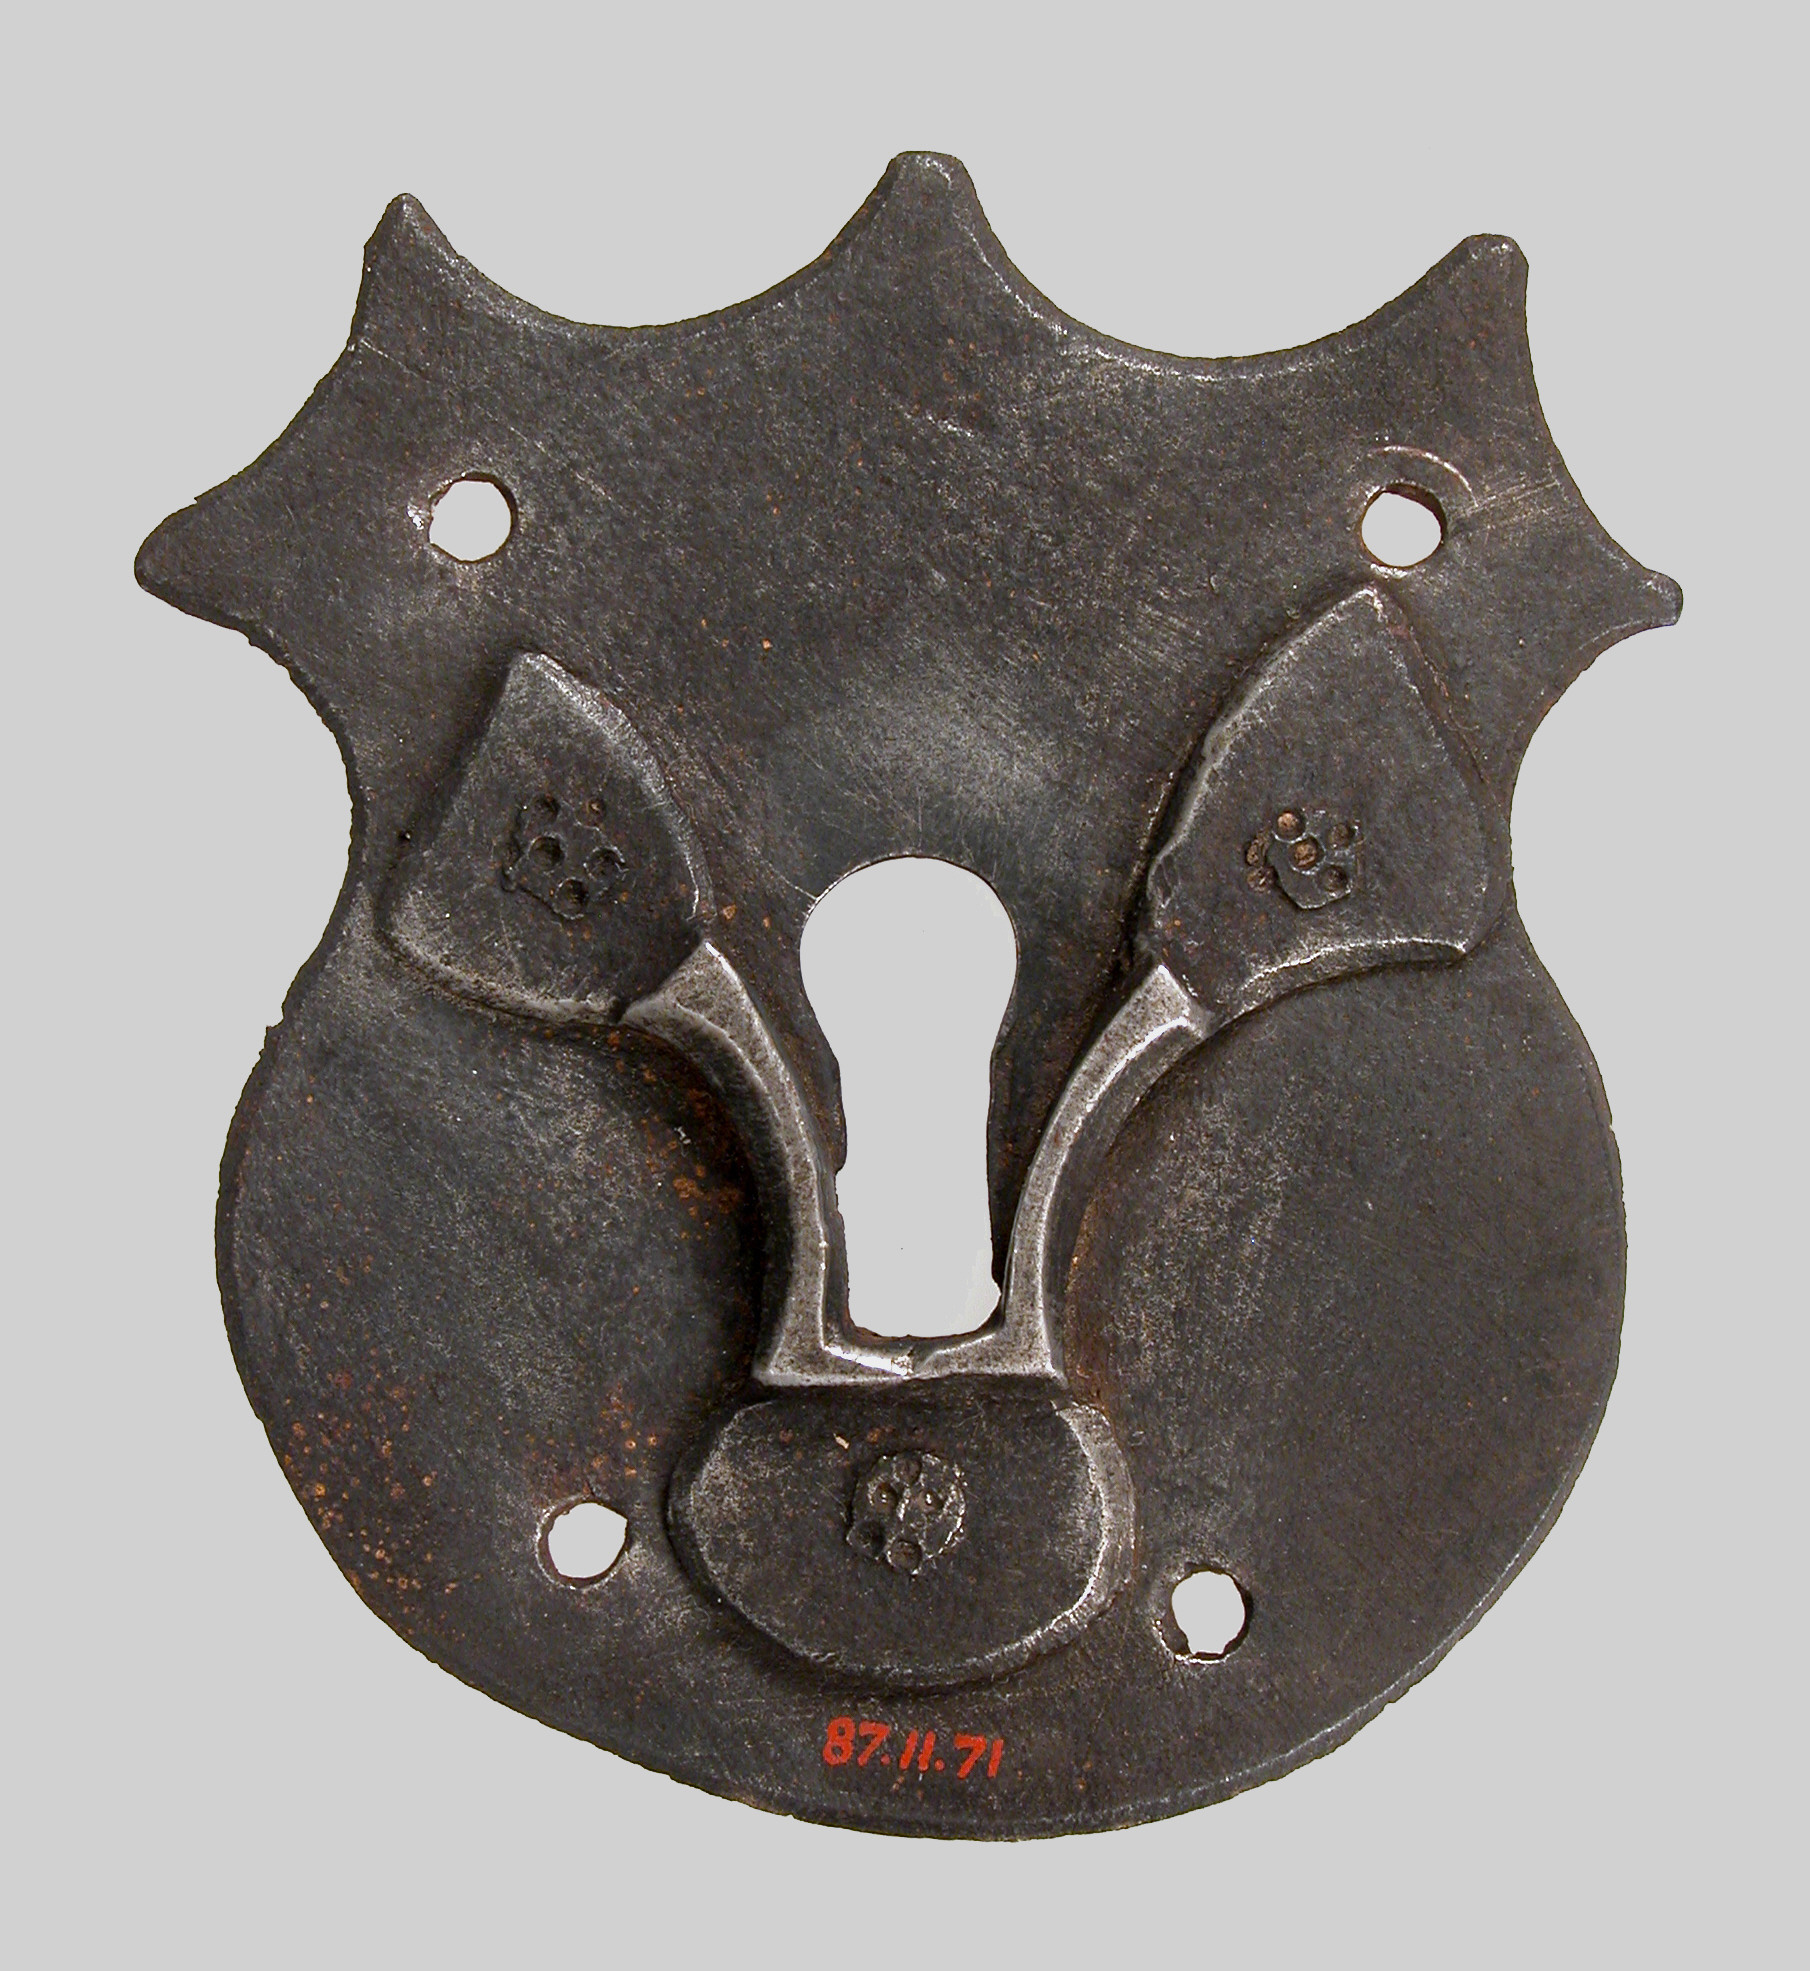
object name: escutcheon plate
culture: german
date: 1501-1600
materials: iron